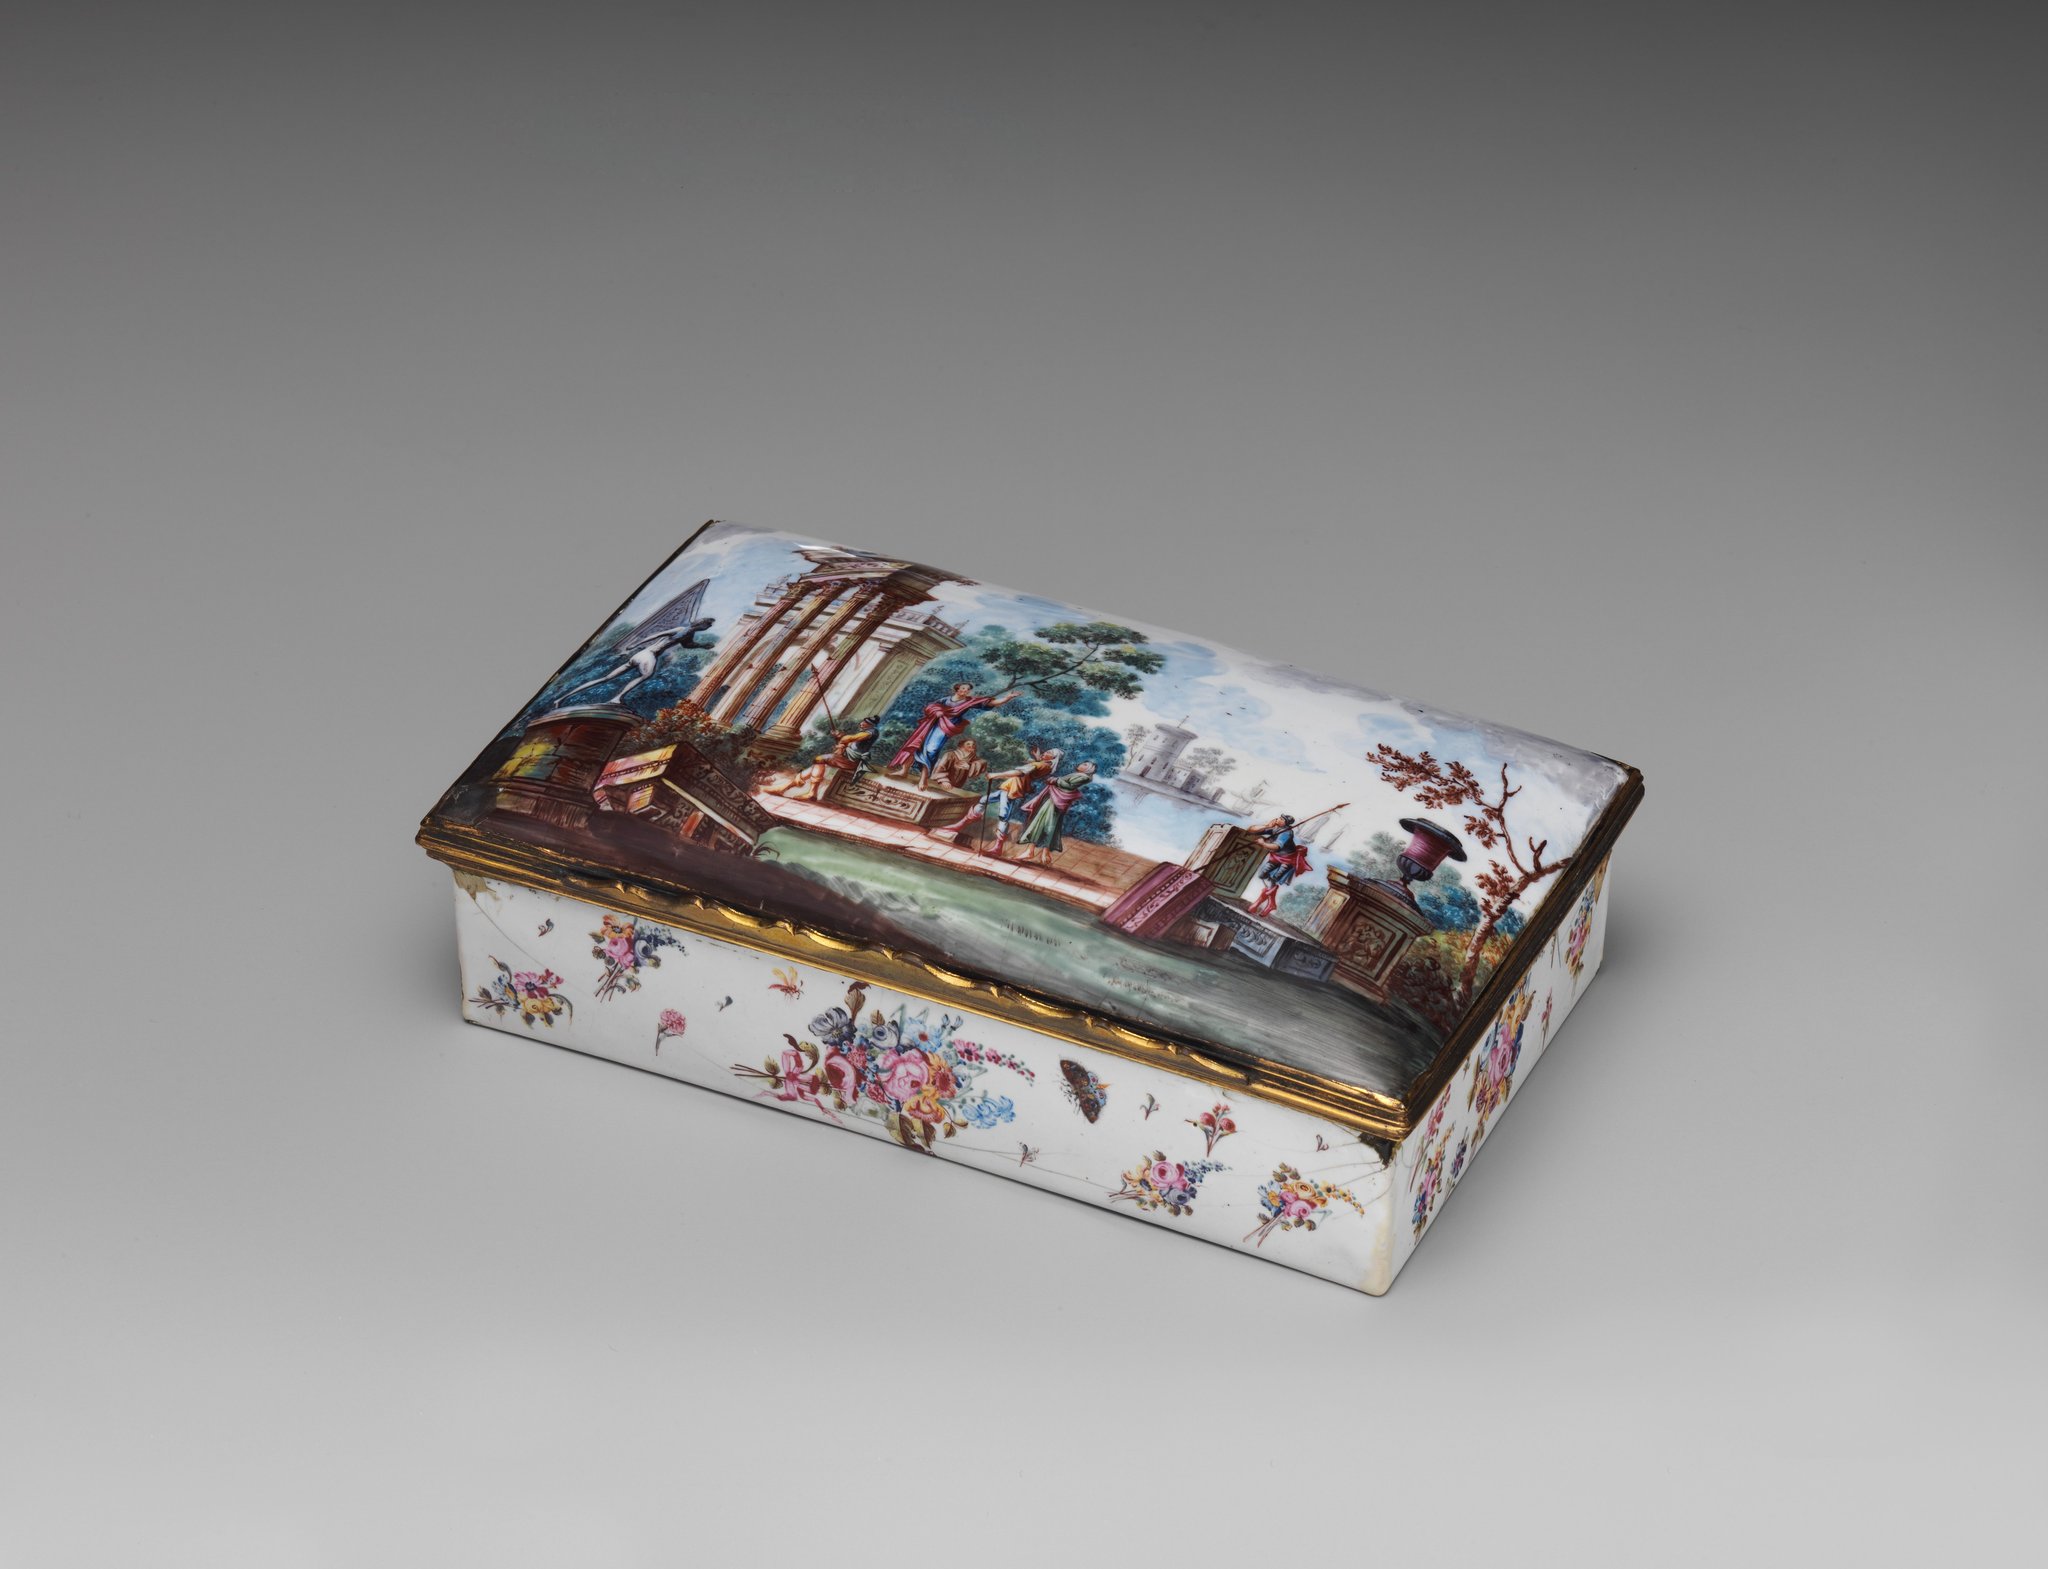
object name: box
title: Writing box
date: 1750-1760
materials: copper, copper gilt, glass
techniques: enamel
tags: men,butterflies,flowers